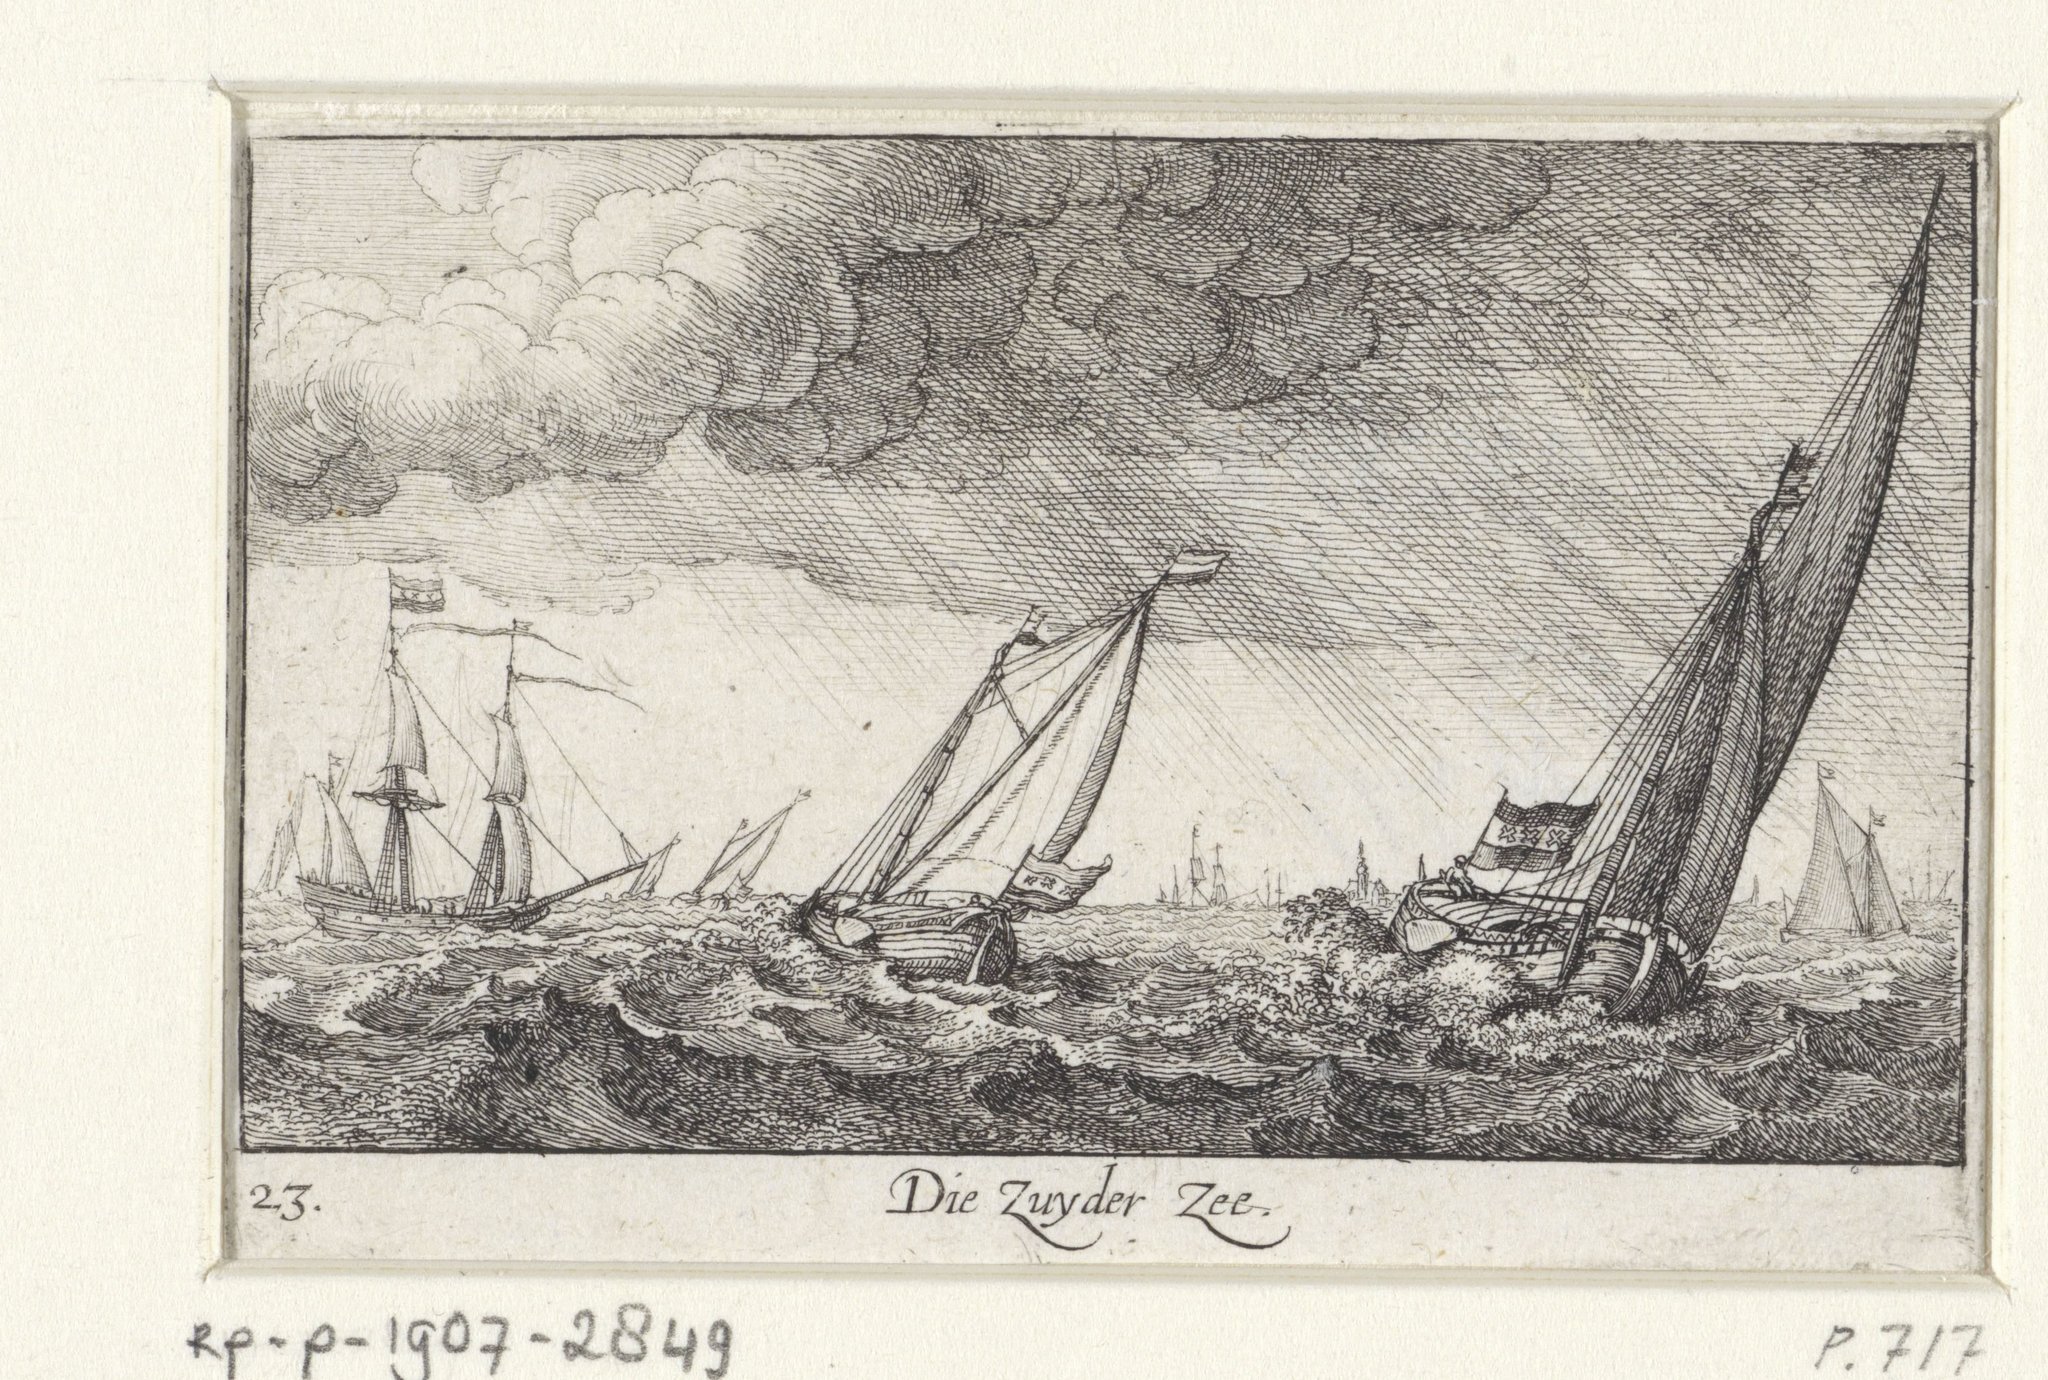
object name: print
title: Die Zuyder Zee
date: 1635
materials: paper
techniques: etching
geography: cologne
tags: city-view, and landscape with man-made constructions, sailing-ship, sailing-boat, storm at sea, zuiderzee